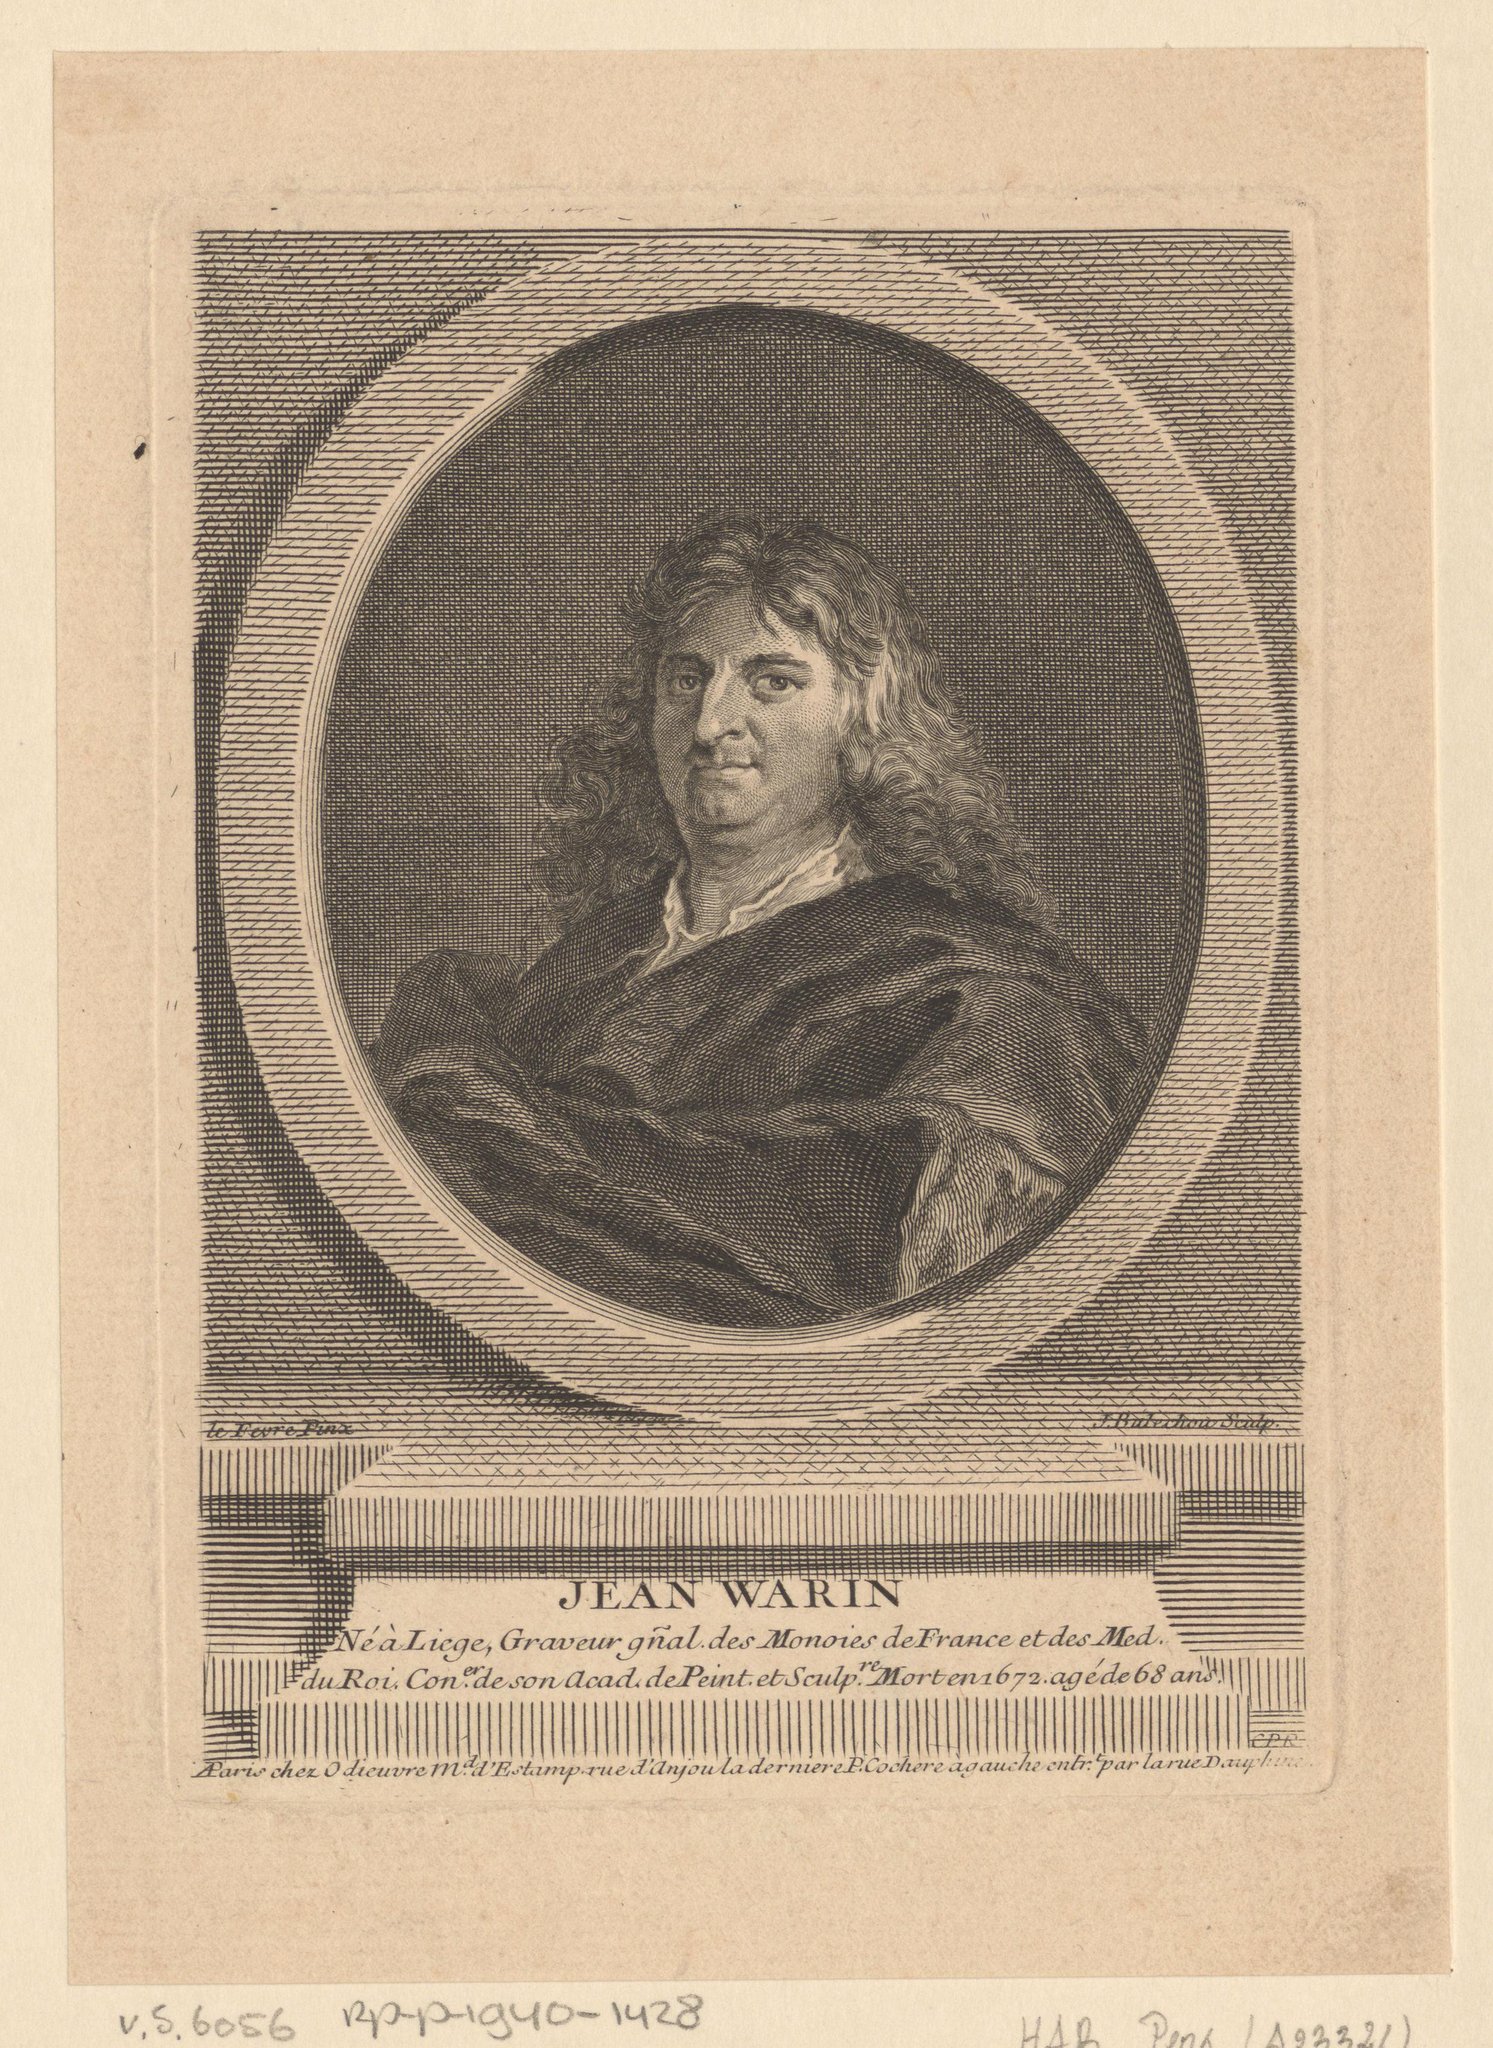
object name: print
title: Portret van Jean Varin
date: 1765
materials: paper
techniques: engraving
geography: paris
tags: sculptor, jean varin, portrait, self-portrait of sculptor, historical persons, portrait, self-portrait of graphic artist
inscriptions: collector's mark: Lugt 2760, collector's mark: Lugt 2228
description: Prent waarschijnlijk uit: Dreux du Radier, Jean François. L'Europe illustré, contenant l'histoire abregée des souverains, des princes, des prélats, des ministres (...). Parijs: Le Breton, 1765, dl. 6.